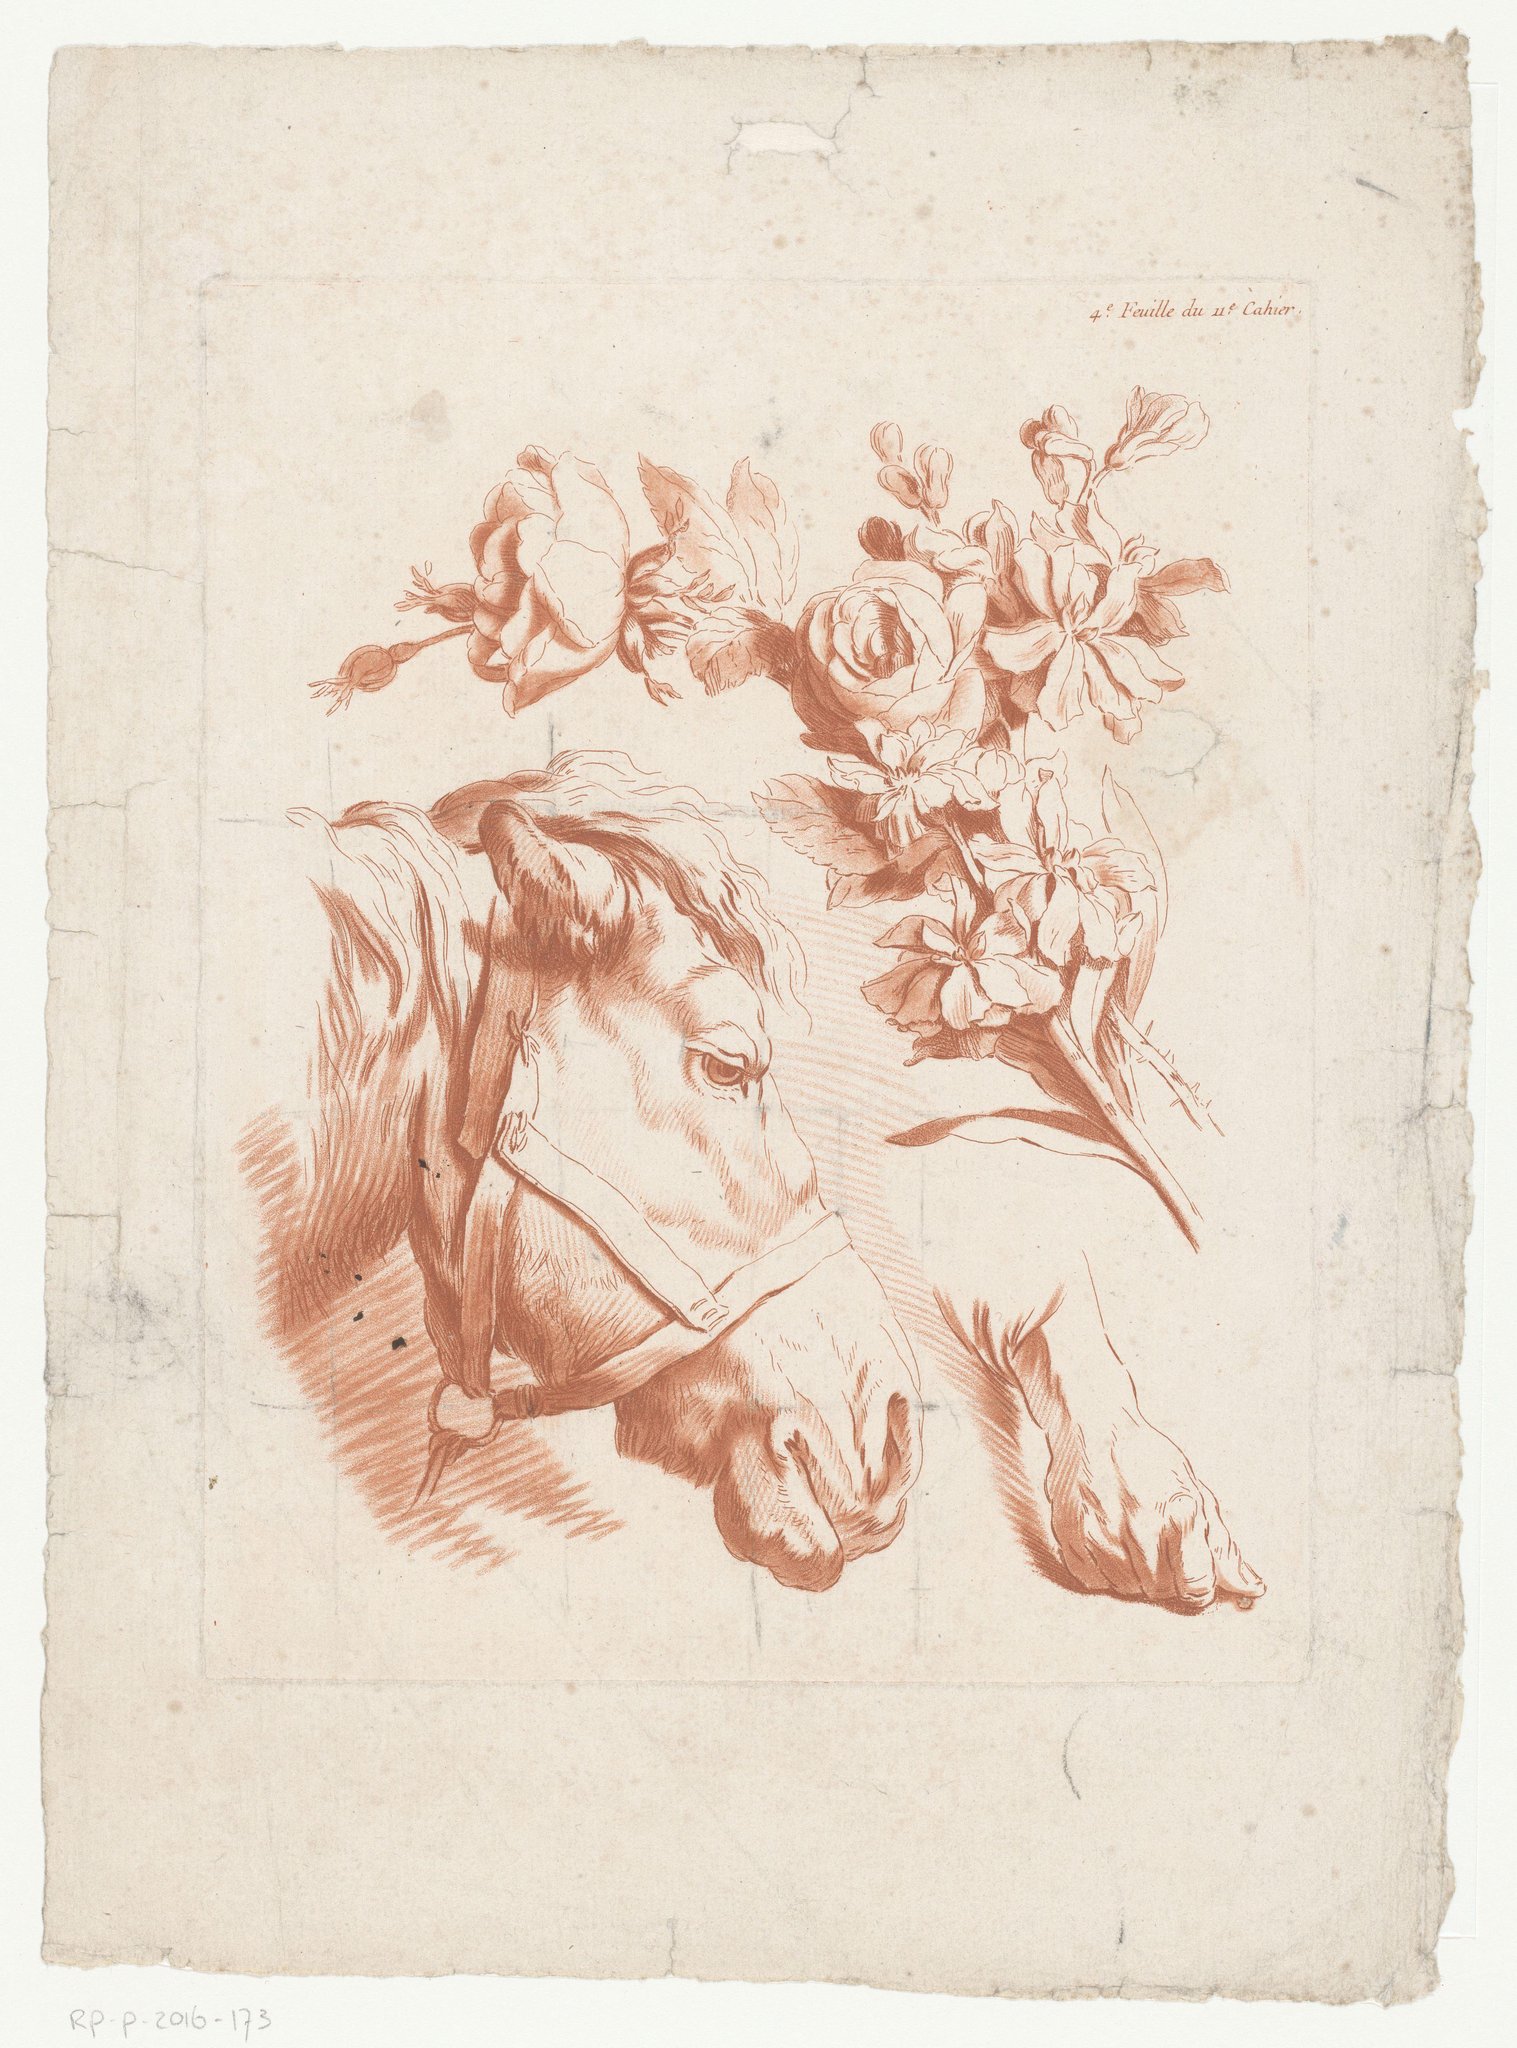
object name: print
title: 4.e Feuille du 11.e Cahier.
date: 1762-1793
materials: paper, pencil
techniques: printmaking, drawing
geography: france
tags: cut flowers; nosegay, bunch of flowers, hand, horse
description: Deze prent maakt deel uit van een album dat uit minstens elf delen bestaat. Dit is het vierde blad van het elfde album. Waarschijnlijk dienden deze albums als voorbeeld voor tekenaars, schilders en graveurs.